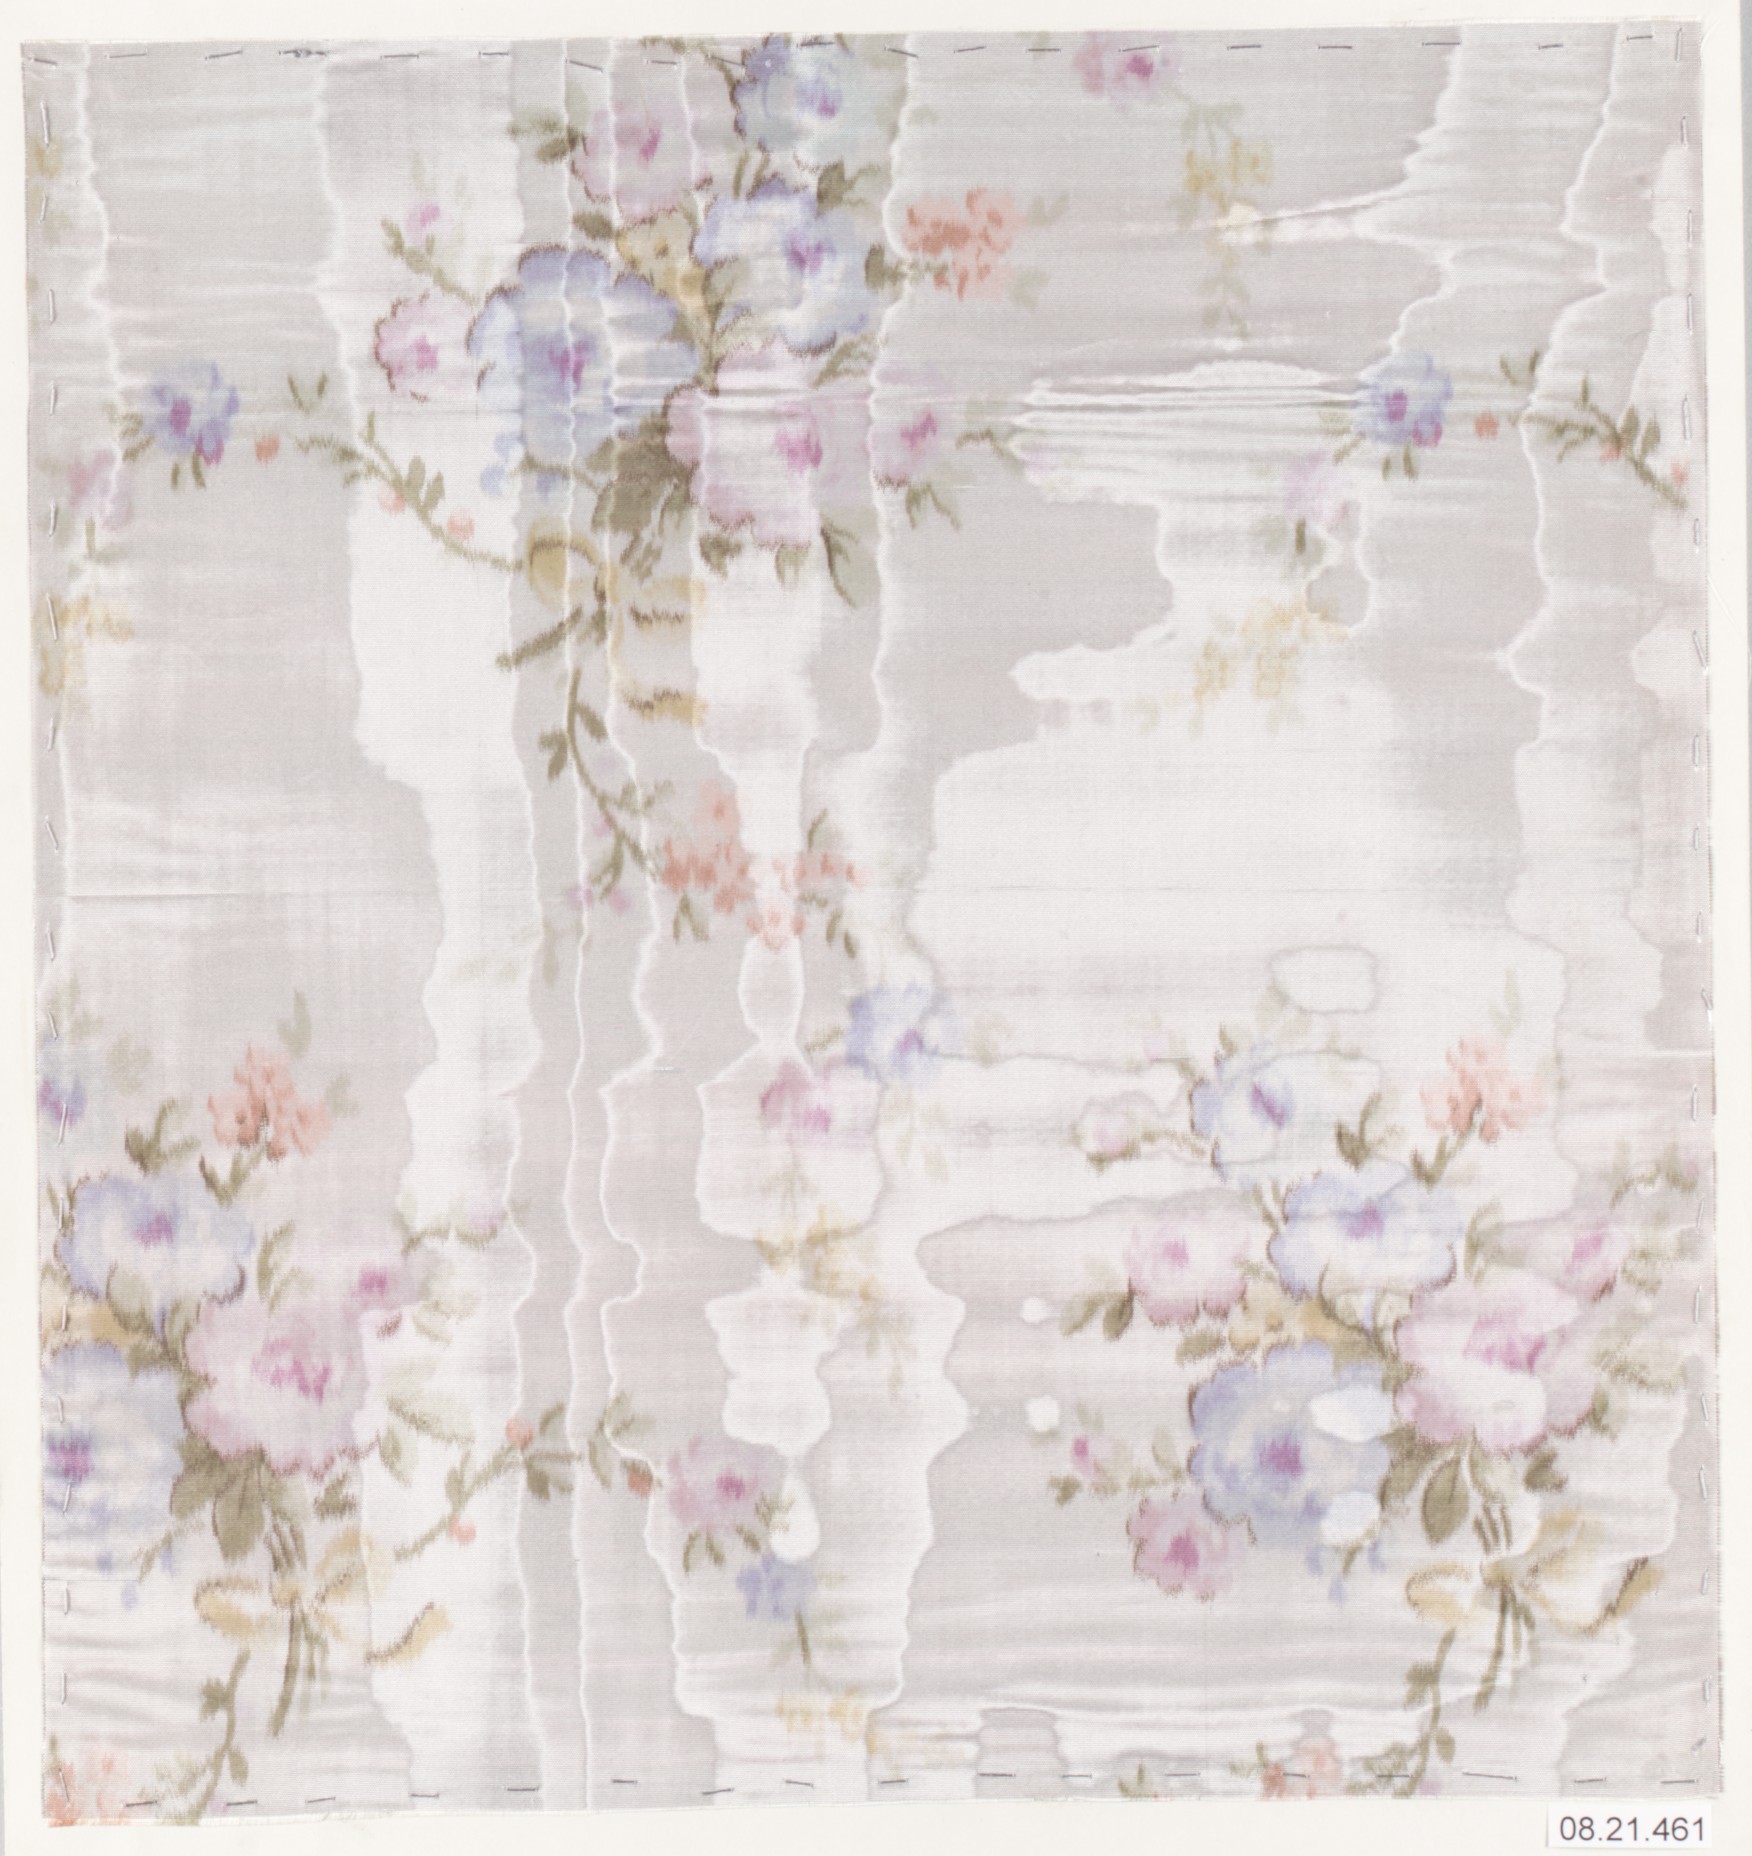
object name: textile sample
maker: Anonymous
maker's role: designer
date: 1900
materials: silk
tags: flowers